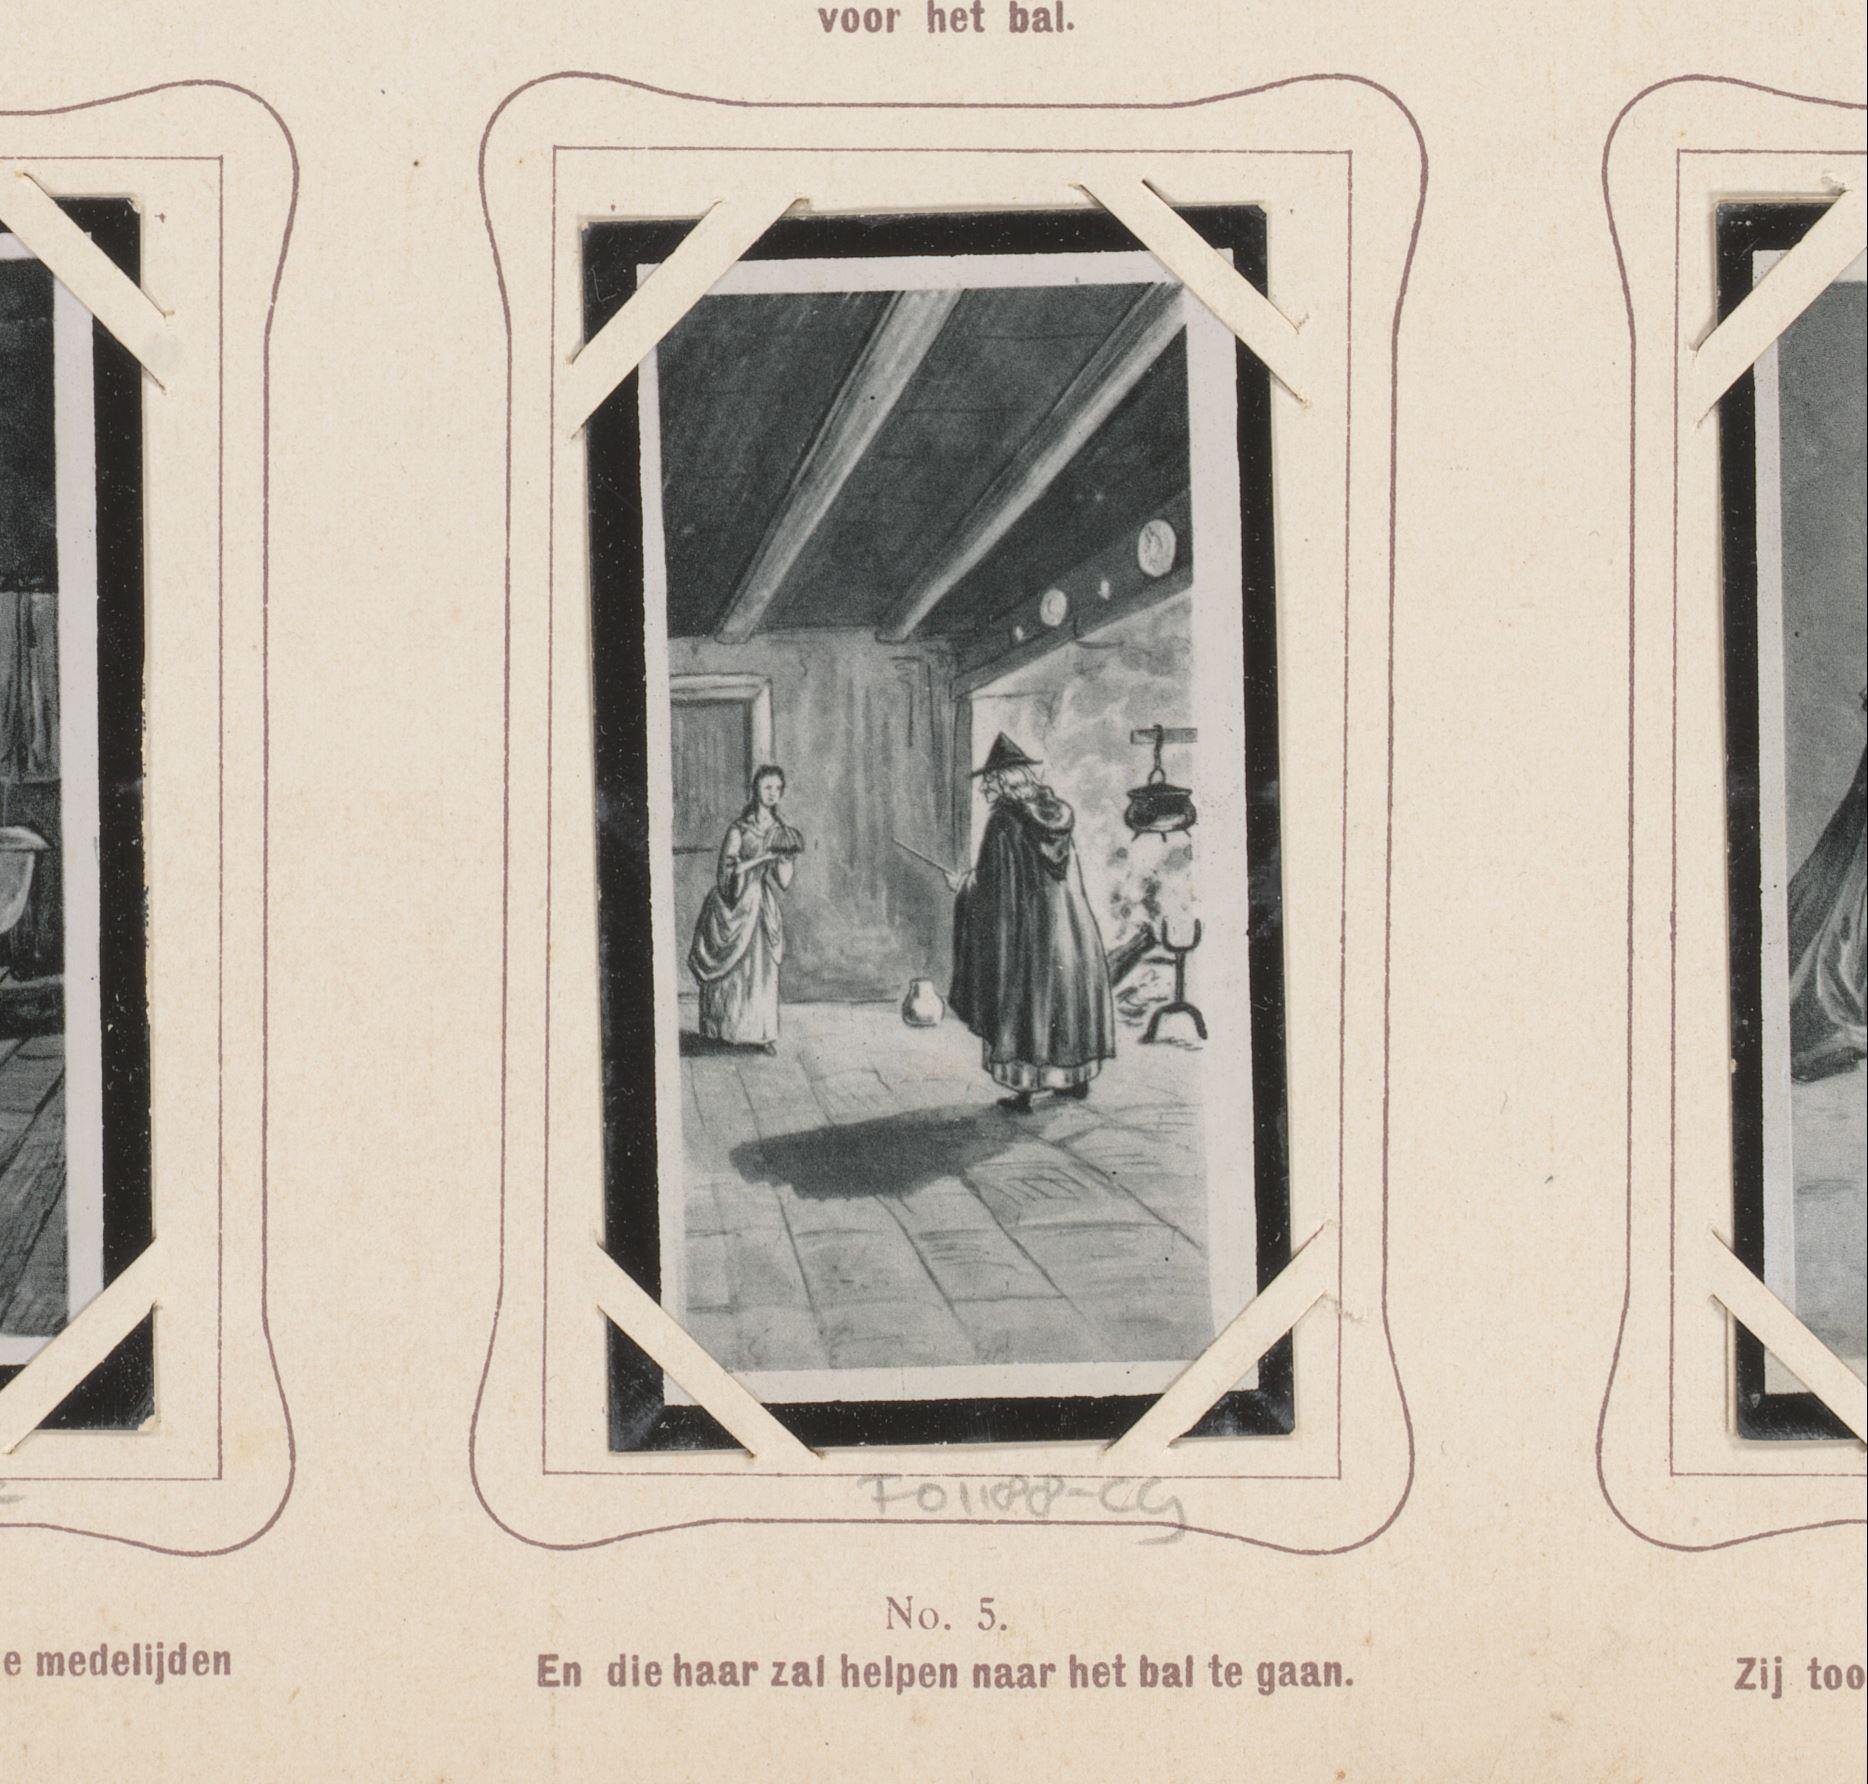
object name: reproduction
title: Reproductie van een tekening van het bezoek van de heks aan Assepoester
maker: Anonymous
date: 1906-1907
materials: paper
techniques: photograph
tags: tales and fairy tales (with title)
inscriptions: inscription: ‘No. 5./ En die haar zal helpen naar het bal te gaan.’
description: Deze prent maakt deel uit van een album.